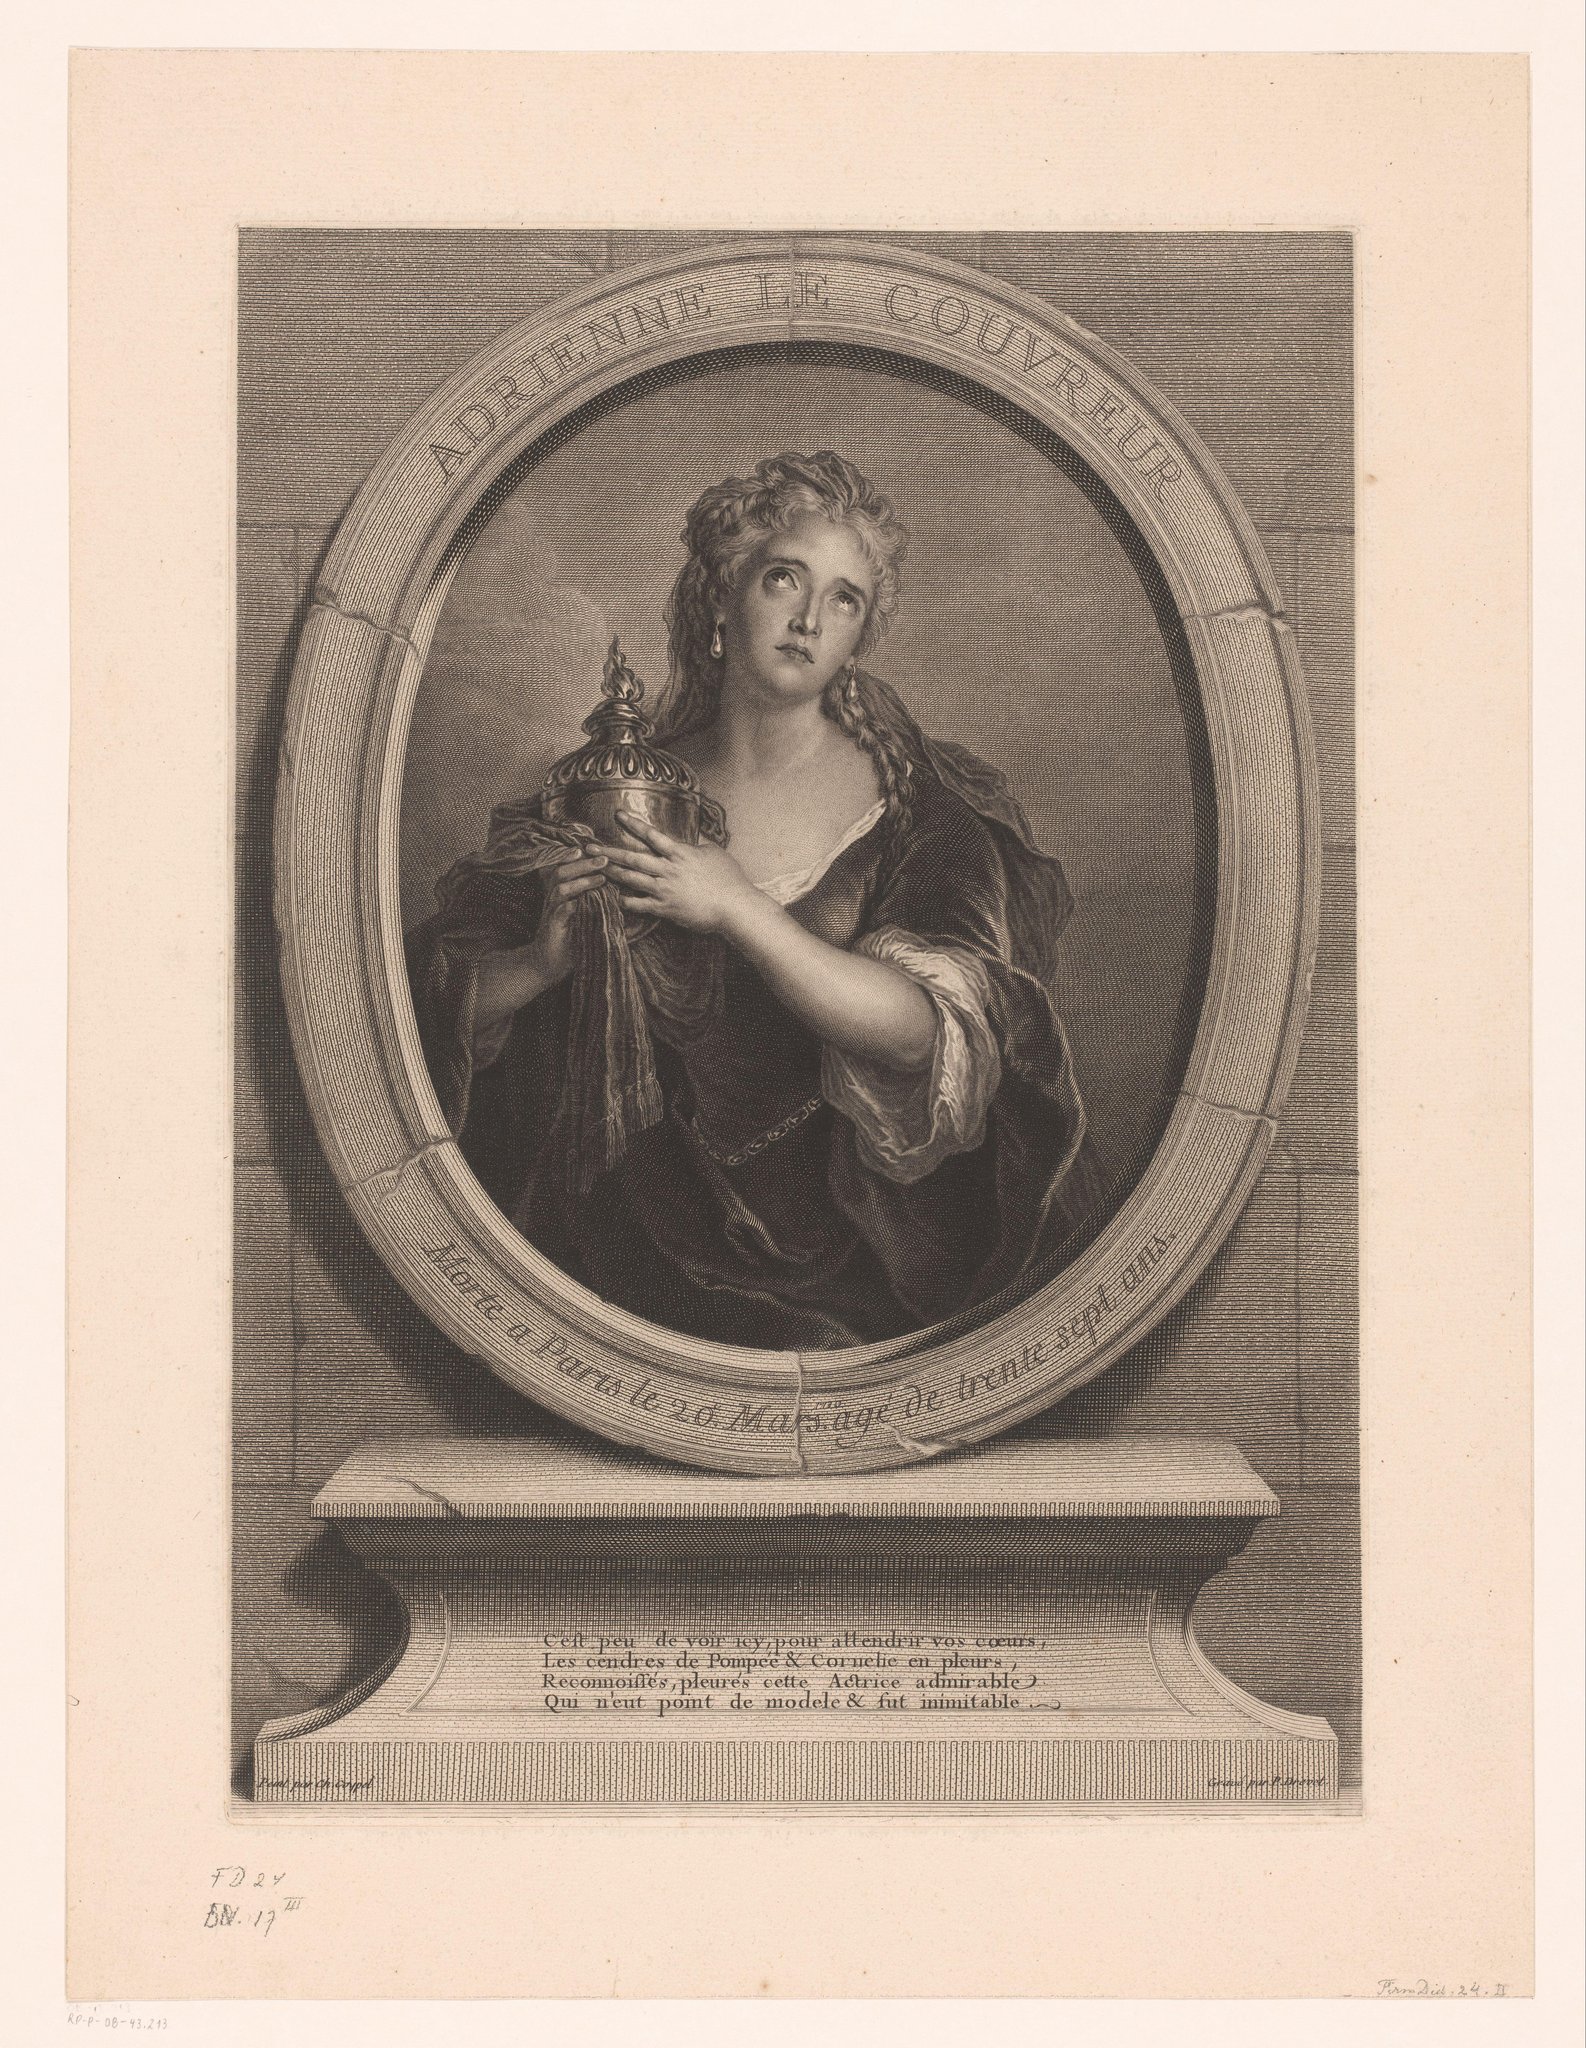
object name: print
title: Adrienne Lecouvret in de rol van Cornelia met een urn met de as van haar man Pompeus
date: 1730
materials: paper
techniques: engraving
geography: france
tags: paris, historical persons - bb - woman, portrait of actor, actress, urn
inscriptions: collector's mark: Lugt 240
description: Actrice Adrienne Lecouvreur als Cornelia in Pierre Corneille's 'La mort de Pompée'. In haar handen een urn met de as van haar man Pompeus.